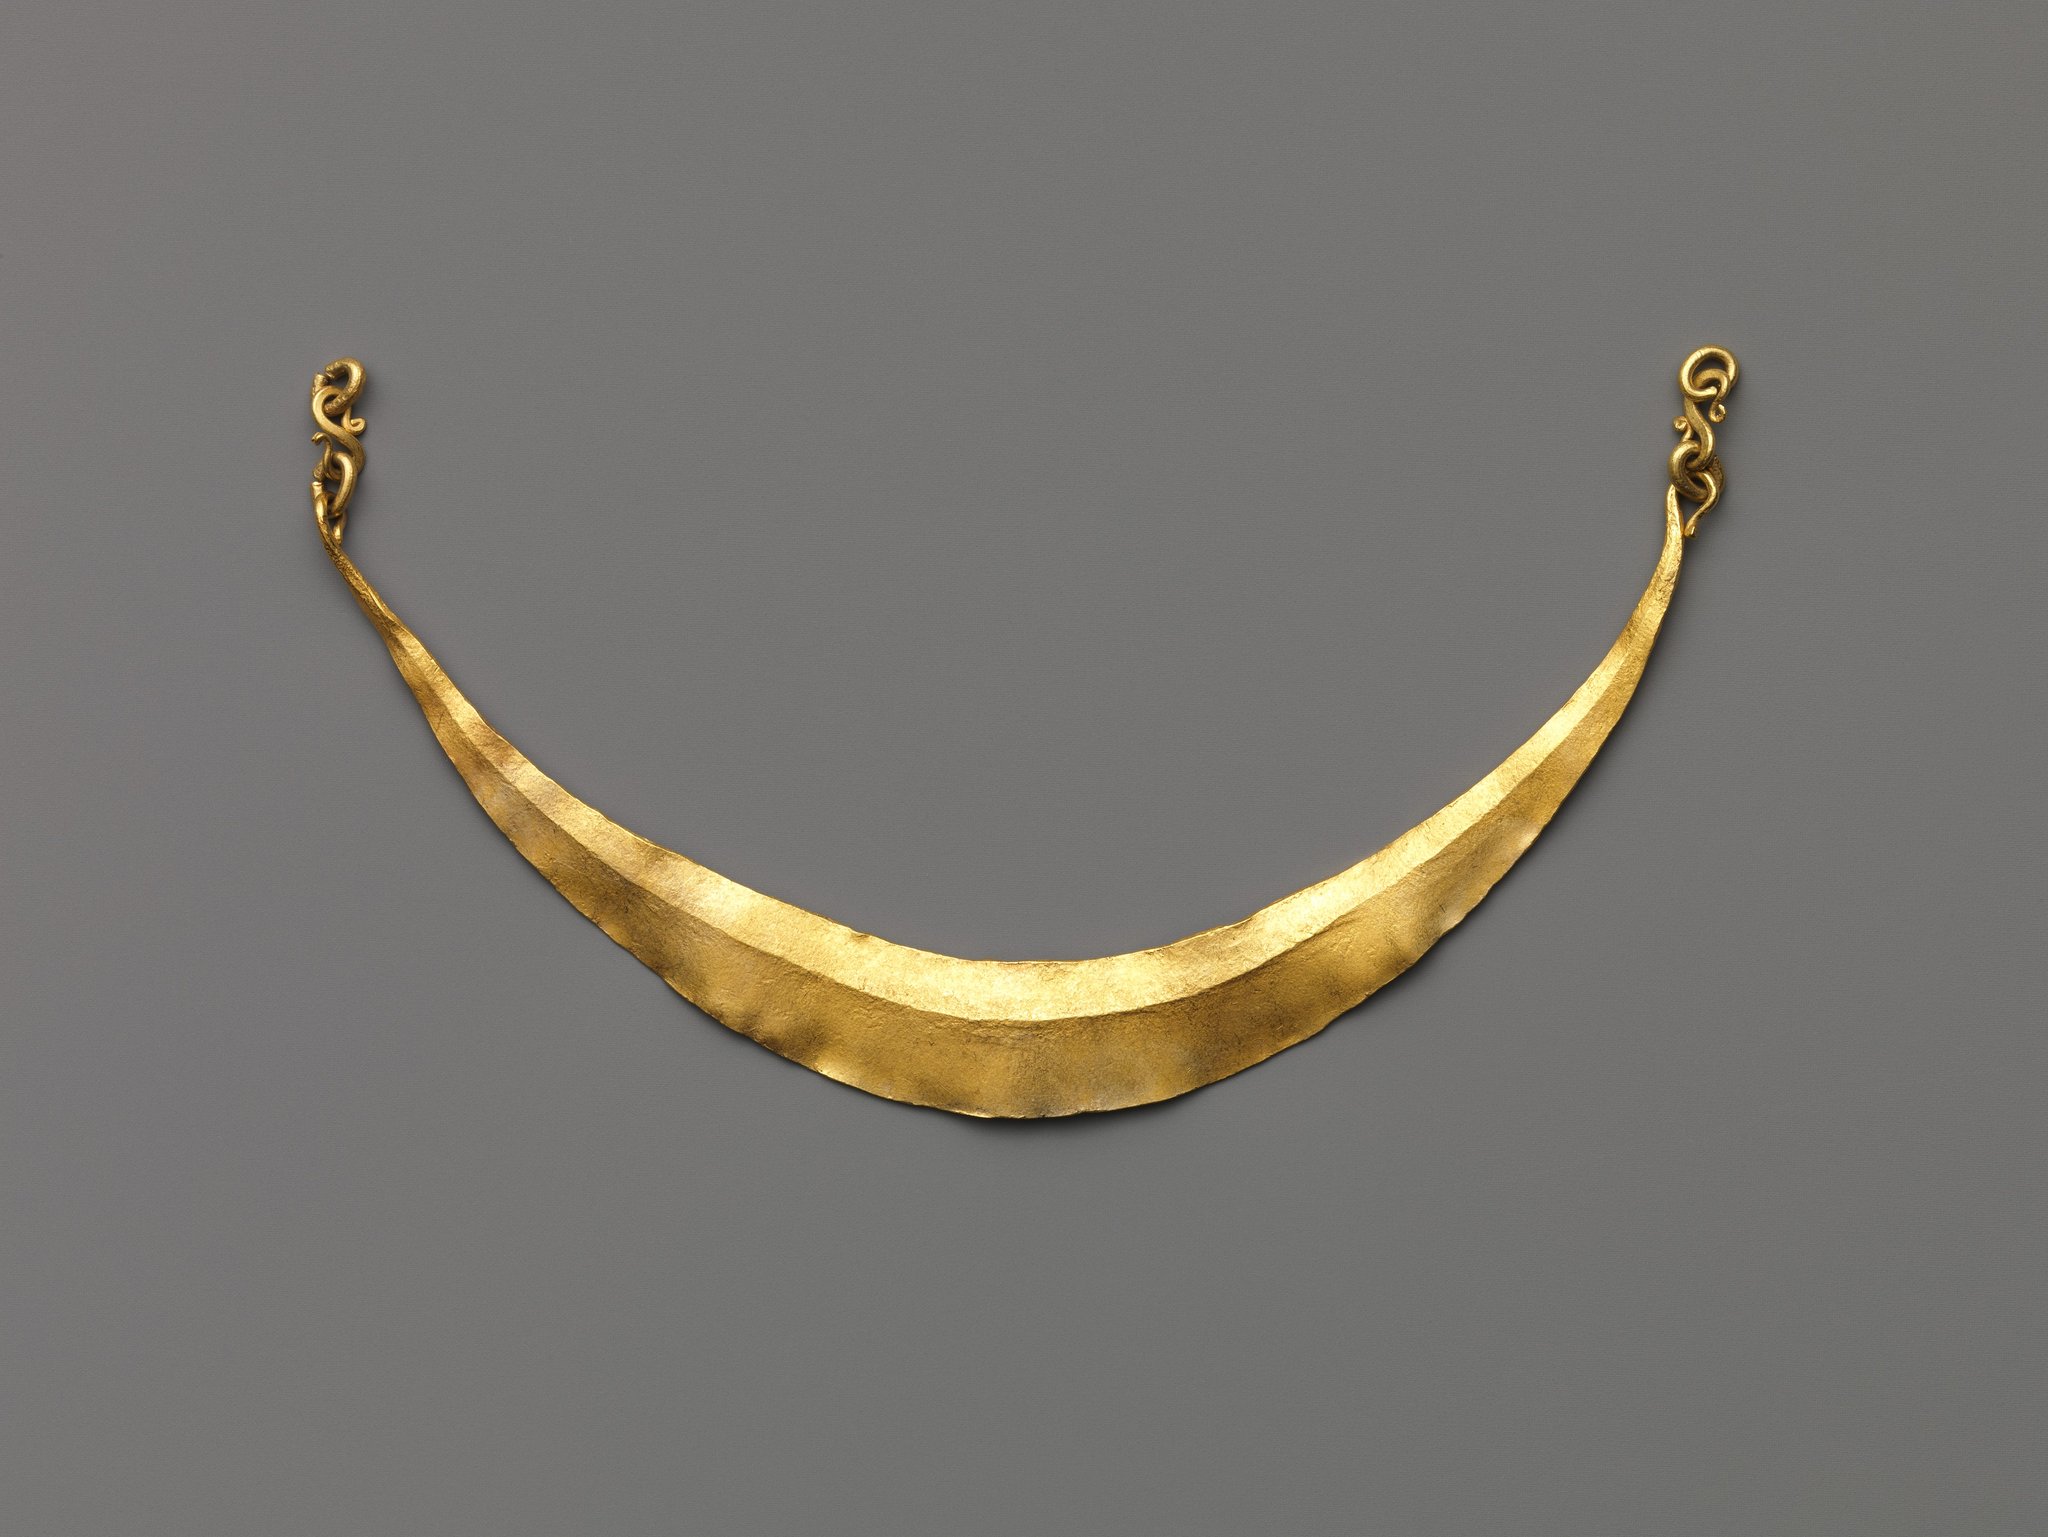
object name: pendant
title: Moon-Shaped Pendant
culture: indonesian, javanese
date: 701-833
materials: gold